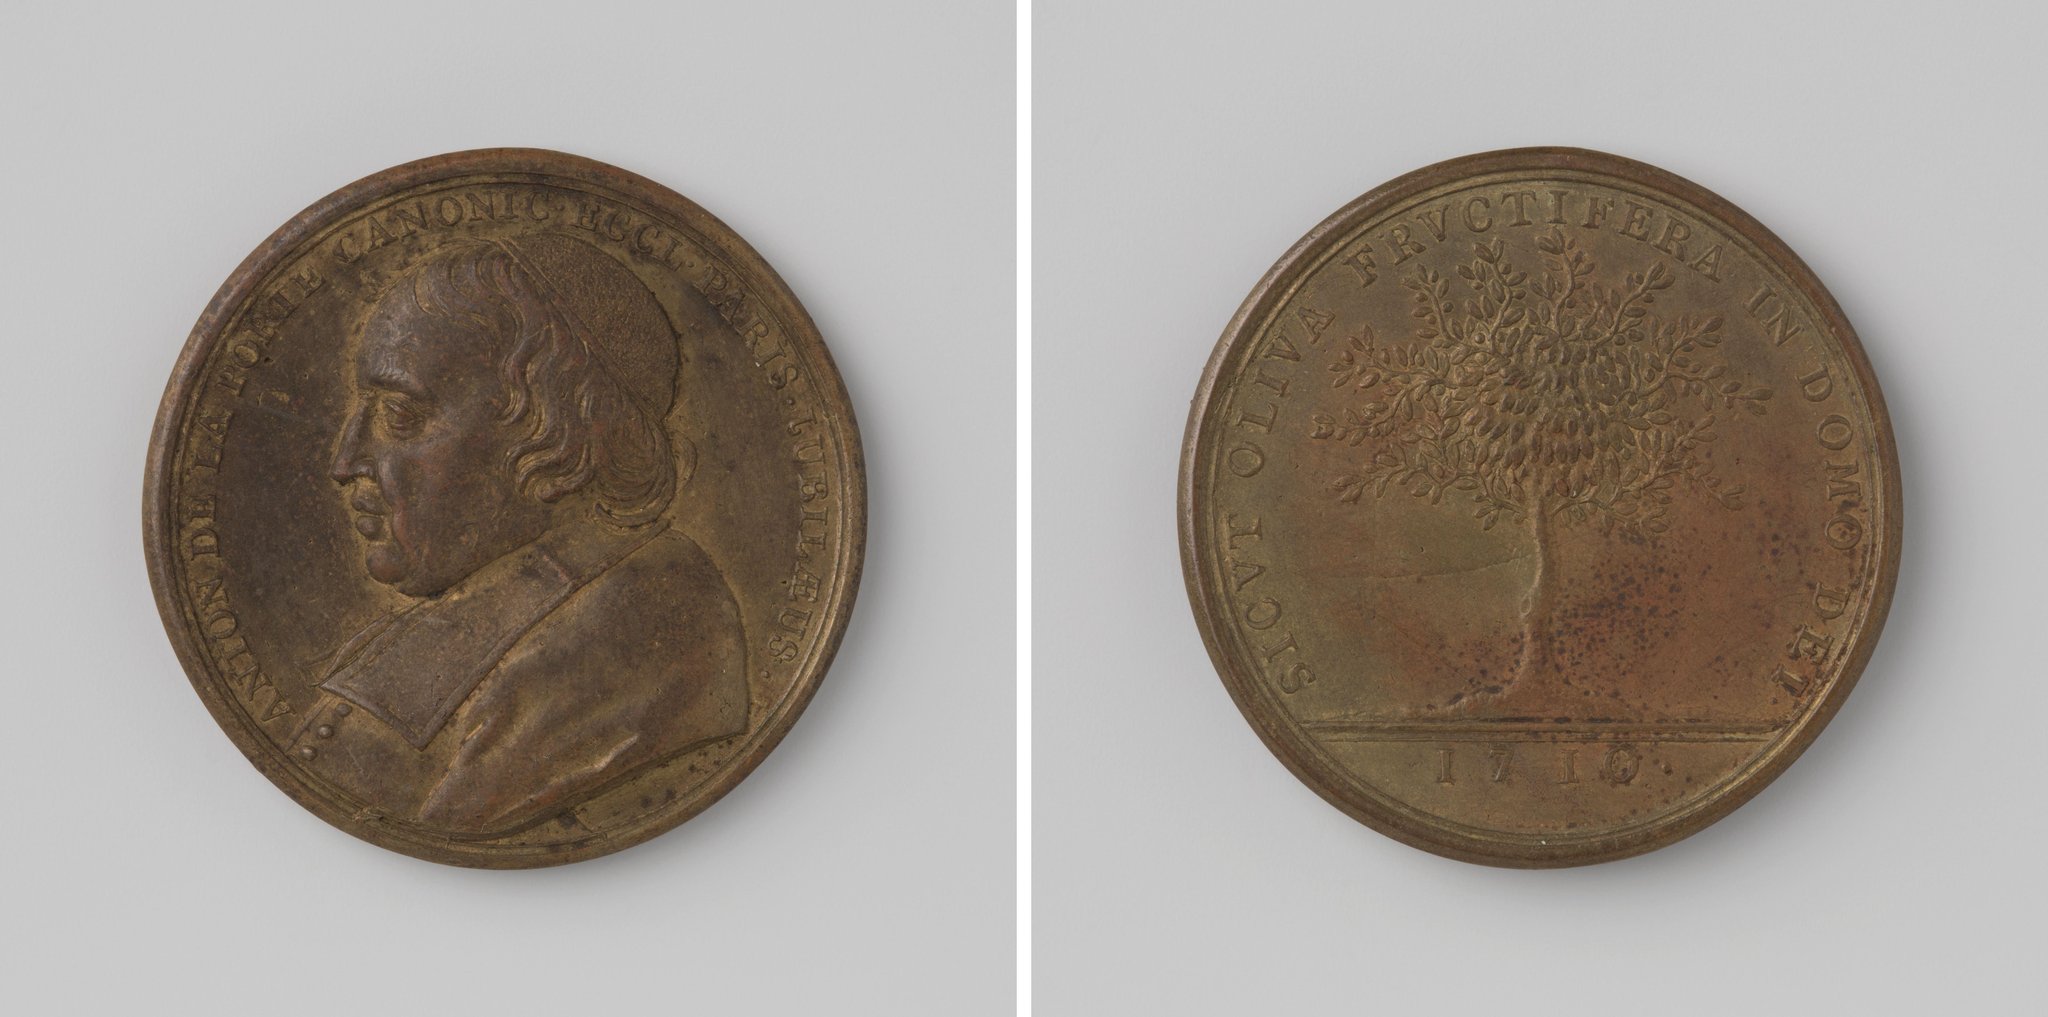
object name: honorary medal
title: Anton de la Porte, kannunik te Parijs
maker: Anonymous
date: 1710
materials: copper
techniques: striking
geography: france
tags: paris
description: Koperen penning. Voorzijde: borststuk man binnen omschrift. Keerzijde: olijfboom binnen omschrift; afsnede: jaartal